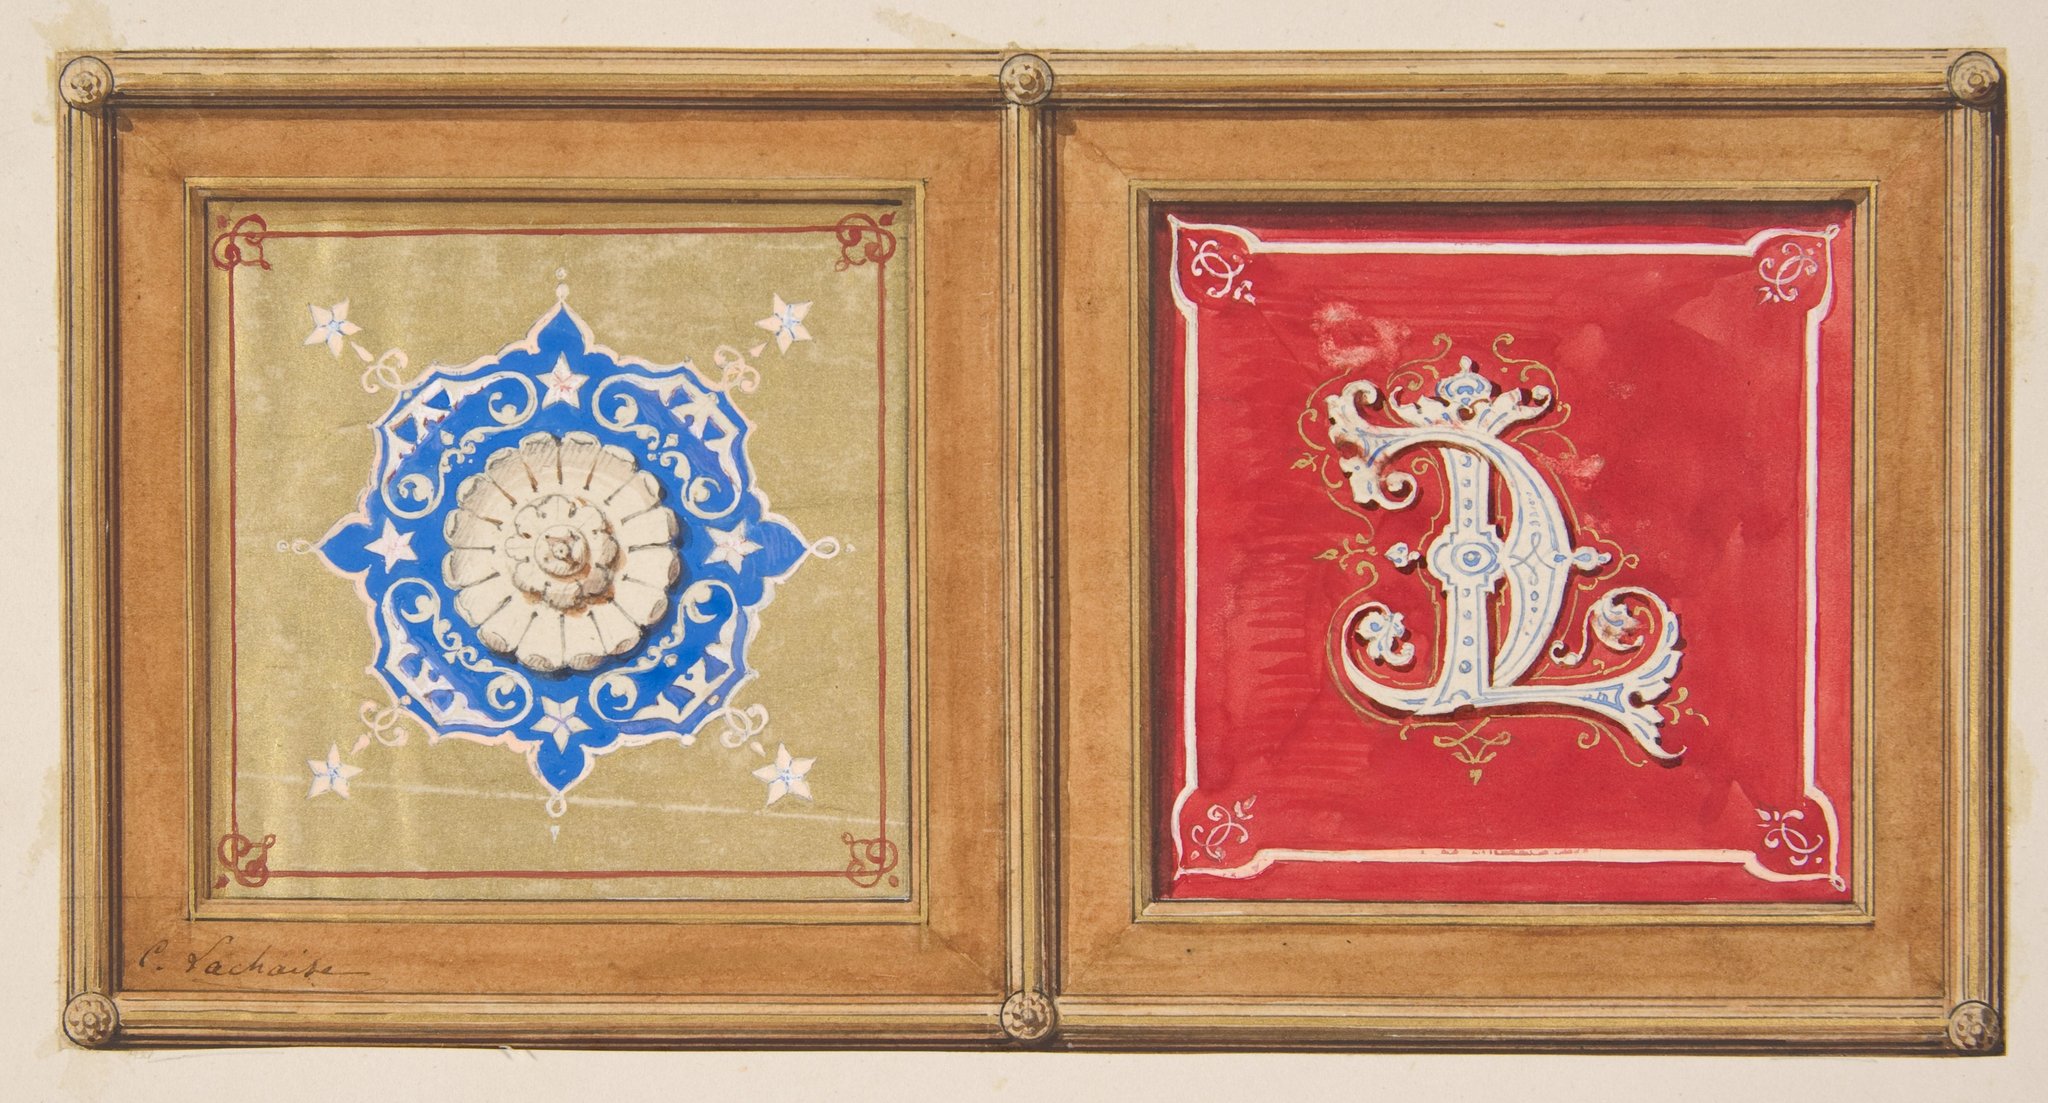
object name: drawing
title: Two alternative designs for the painted decoration of a panel (one with the intertwined initials CL)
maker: jules-edmond-charles lachaise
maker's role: artist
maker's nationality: french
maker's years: 1897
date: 1801-1900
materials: gold paint, ink, paper, watercolor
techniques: pen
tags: insignia